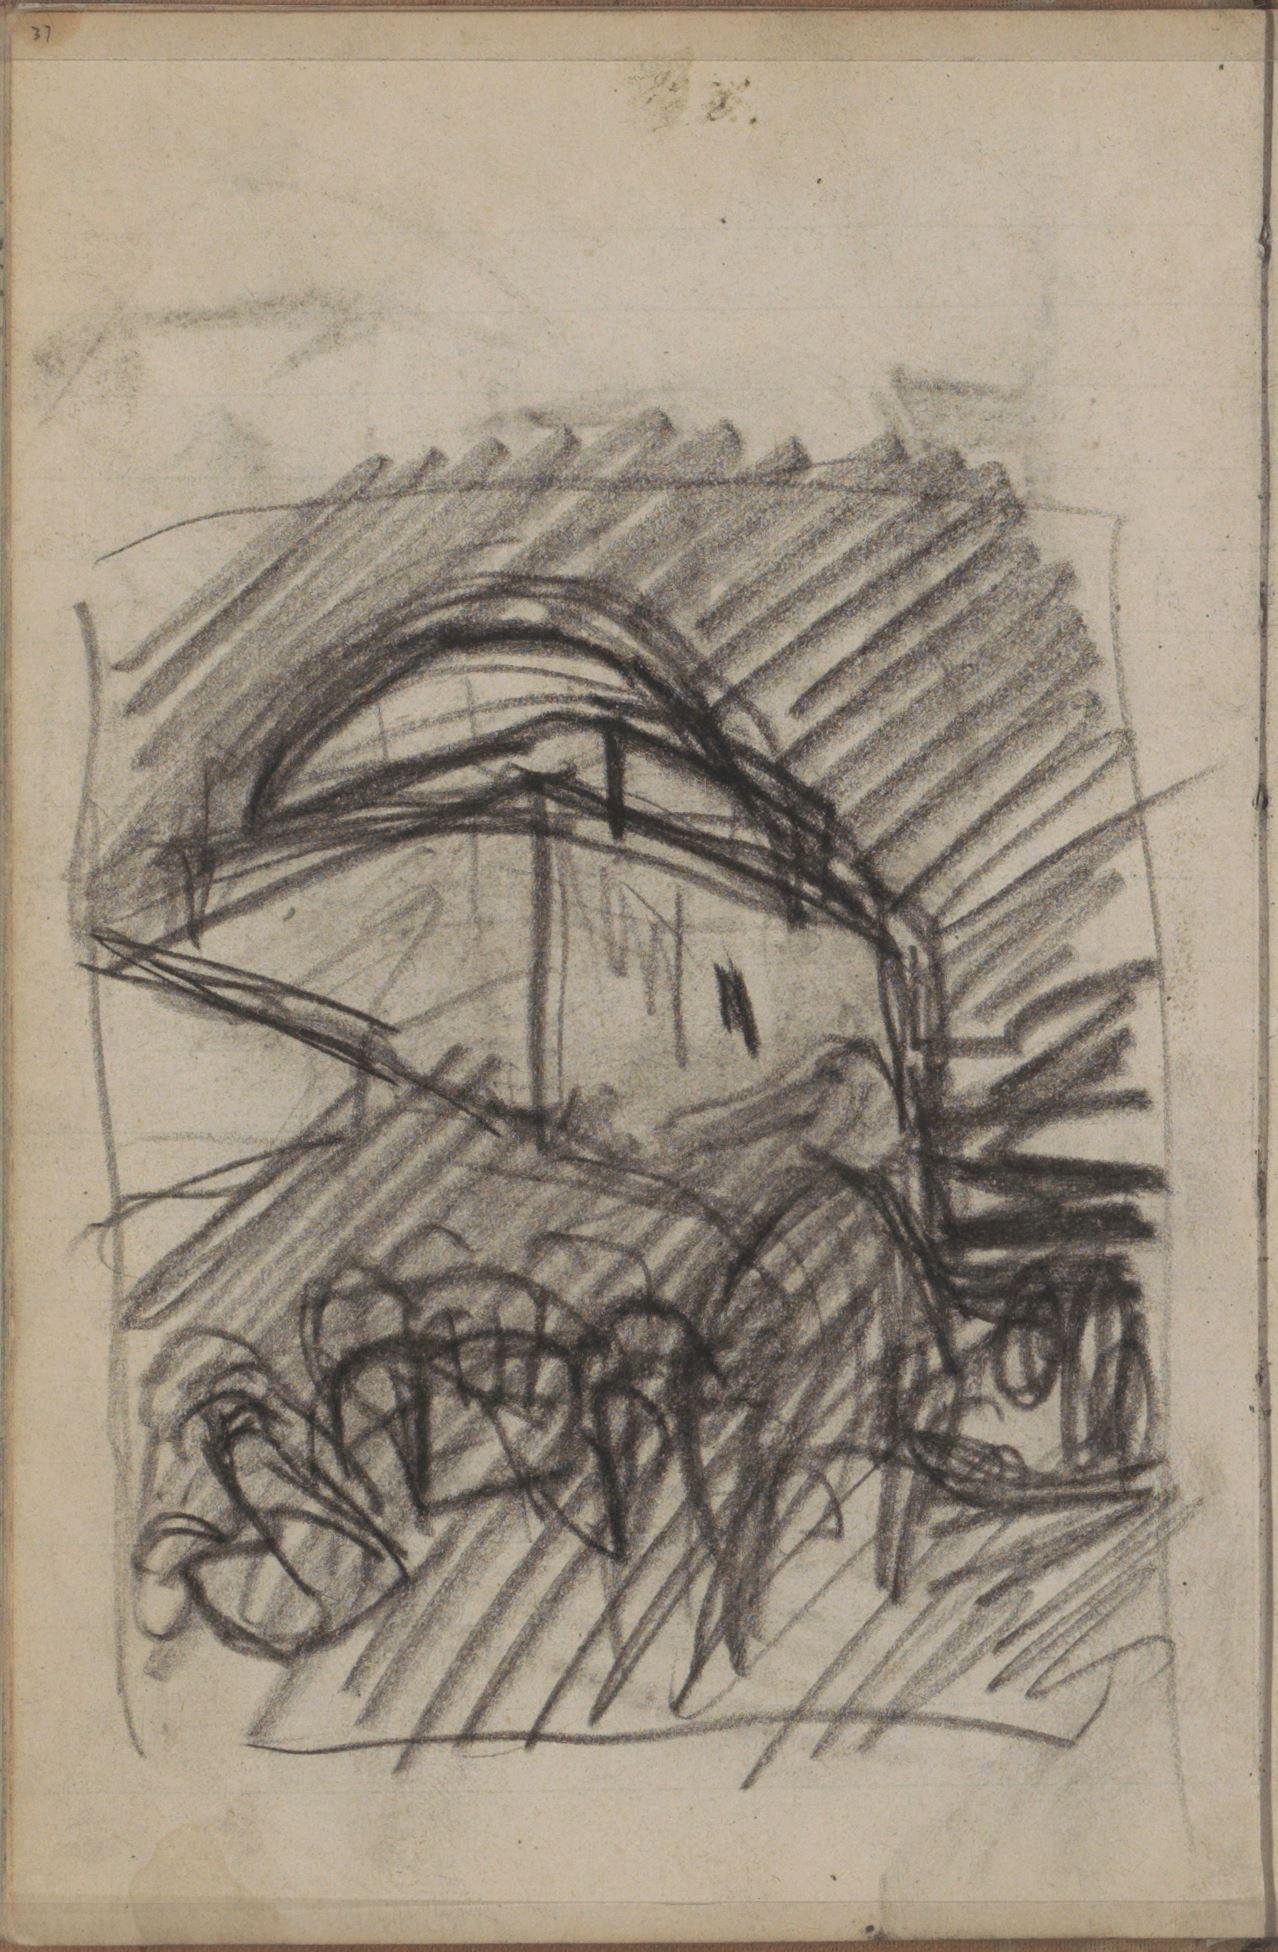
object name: sketchbook leaf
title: Gebouw met een koepeldak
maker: marius bauer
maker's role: draughtsman, print maker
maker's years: 1867-1932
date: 1888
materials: chalk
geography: istanbul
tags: dome ~ architecture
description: Pagina 37 uit een schetsboek met 56 bladen.